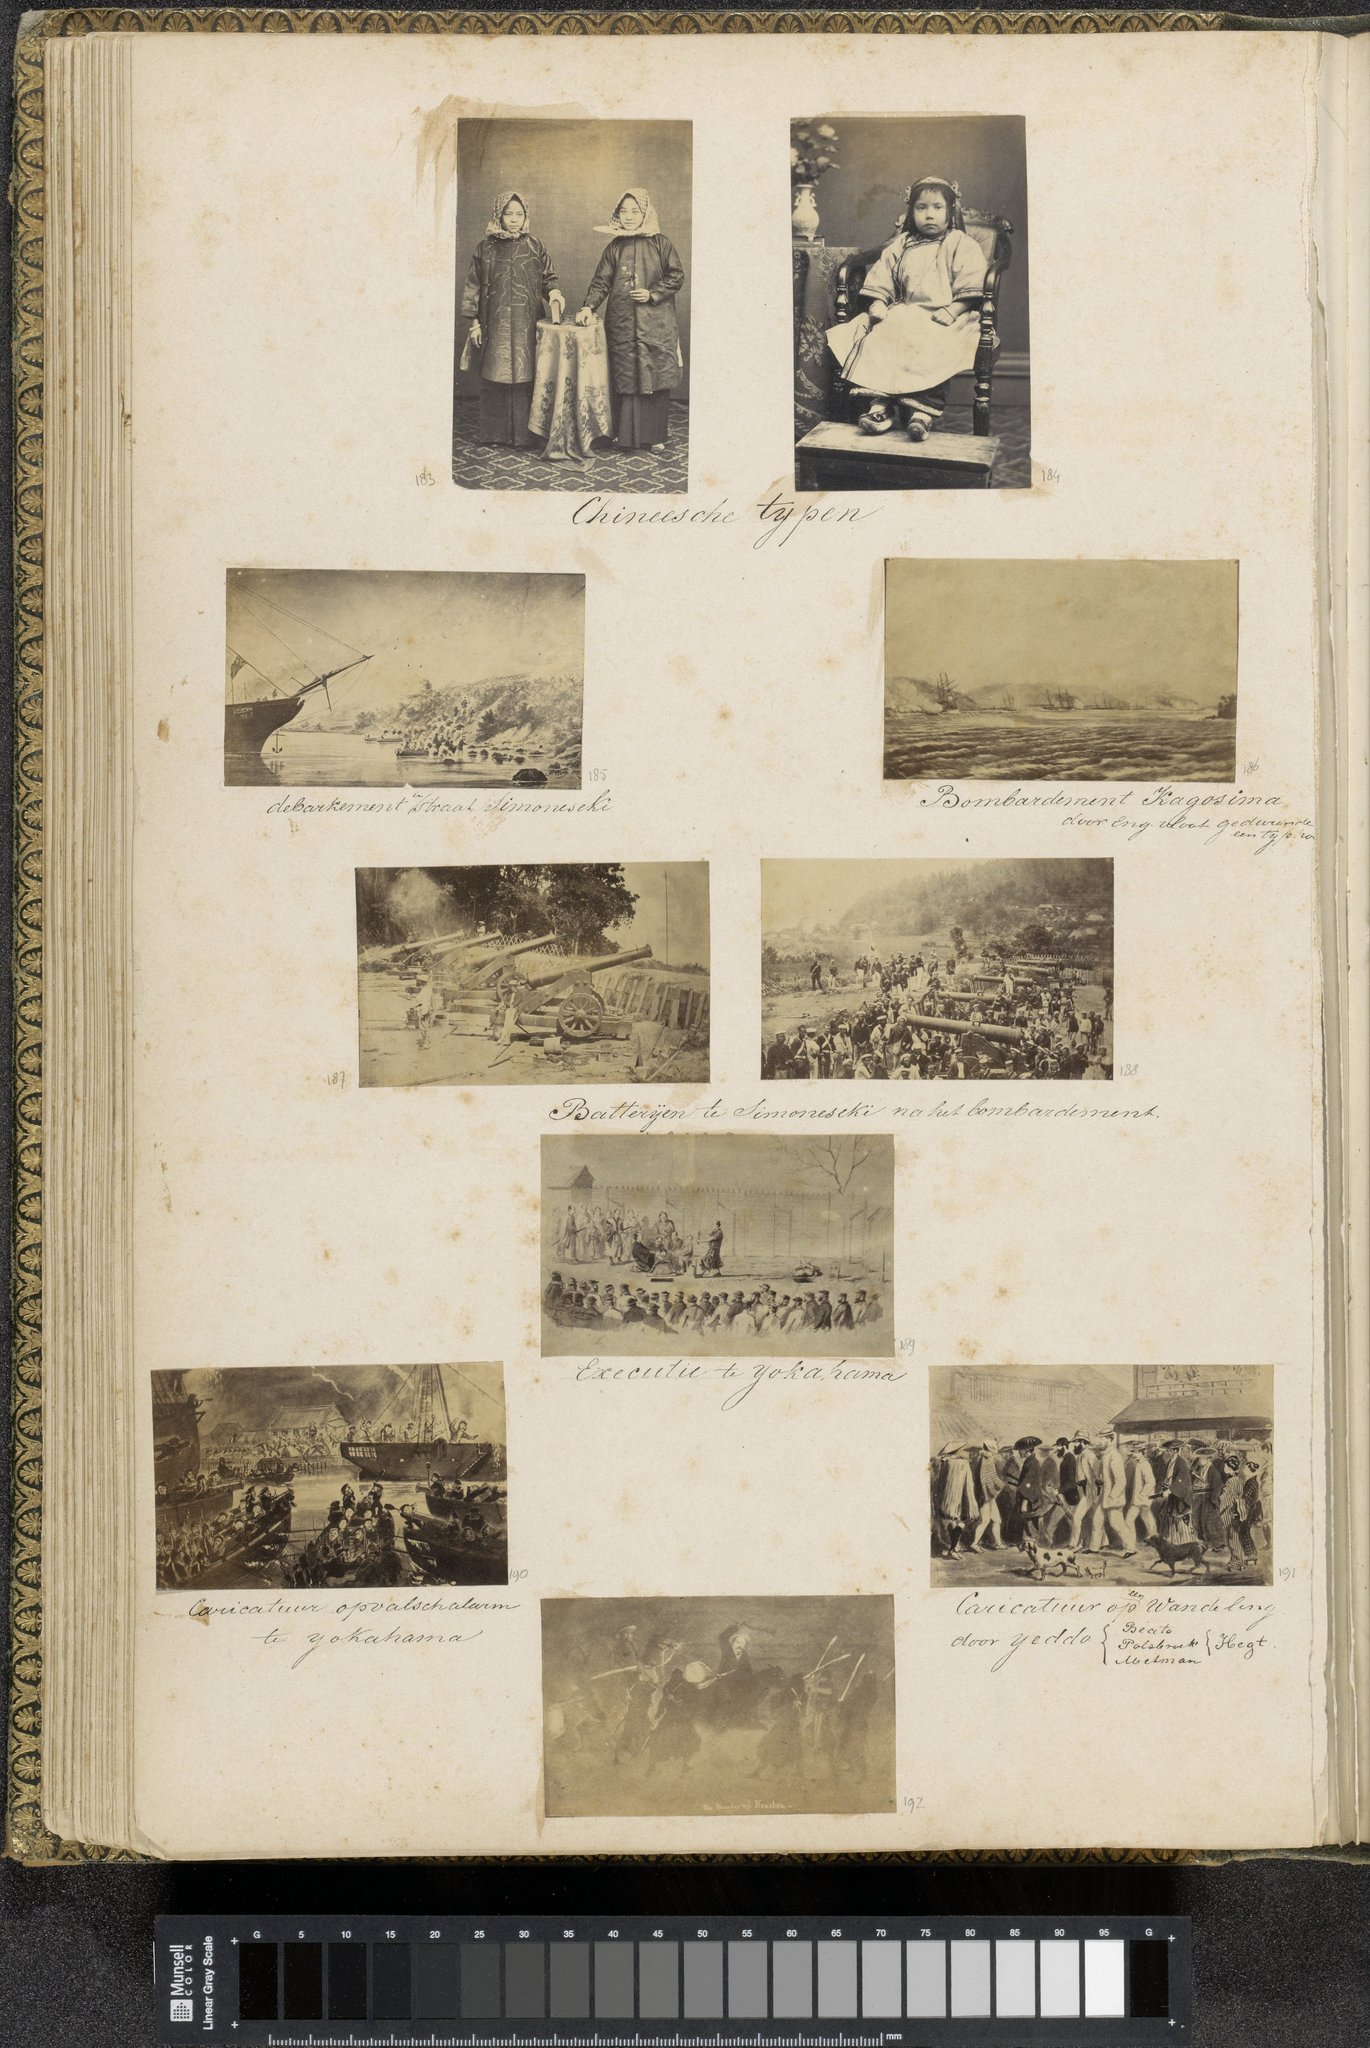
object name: reproduction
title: Fotoreproductie van (vermoedelijk) een tekening voorstellend een karikatuur van een wandeling door Edo van vier mannen, aangeduid als 'Beato, Polsbroek, Metman, Hegt'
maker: Anonymous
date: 1863-1880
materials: paper, photographic support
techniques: albumen print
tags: guardian, street (+ city(-scape) with figures, staffage)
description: Onderdeel van Fotoalbum van Robert Daniel Crommelin (1841-1907).